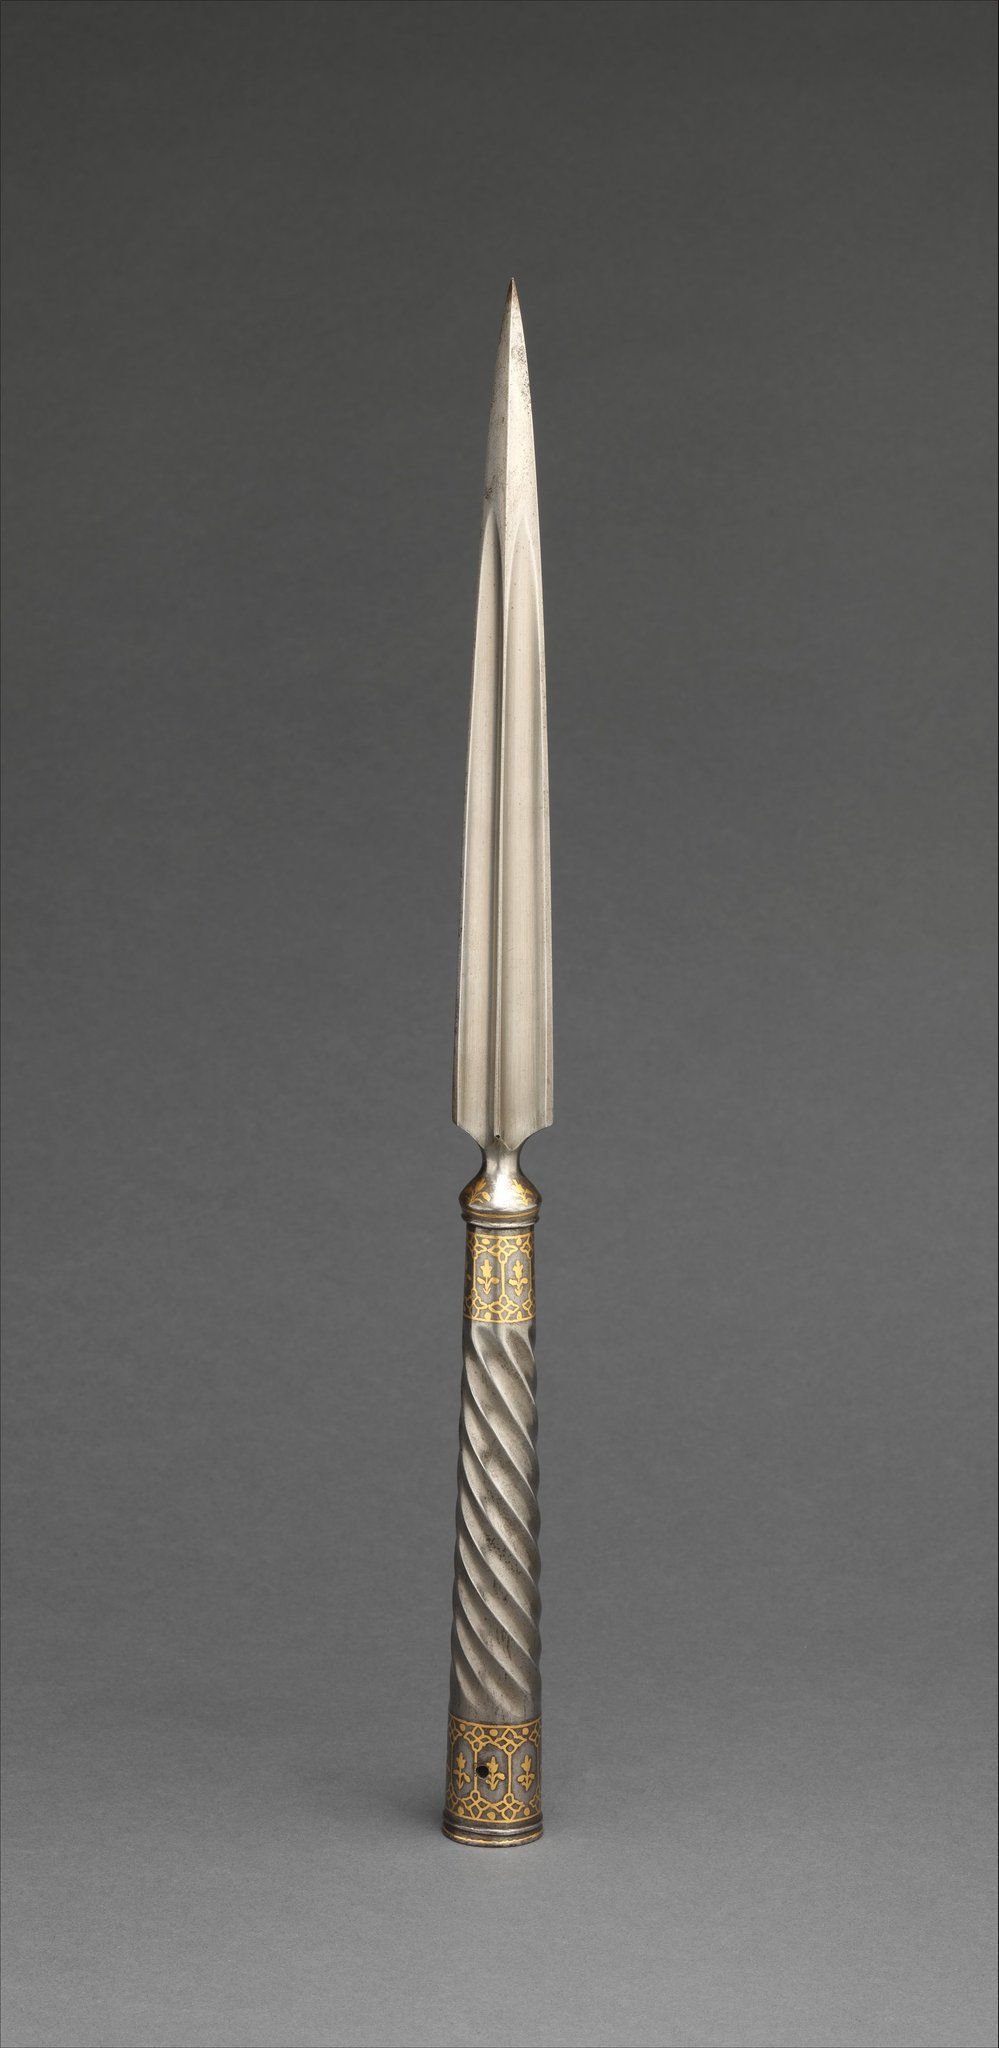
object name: spear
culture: north indian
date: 1601-1700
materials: gold, steel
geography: north india